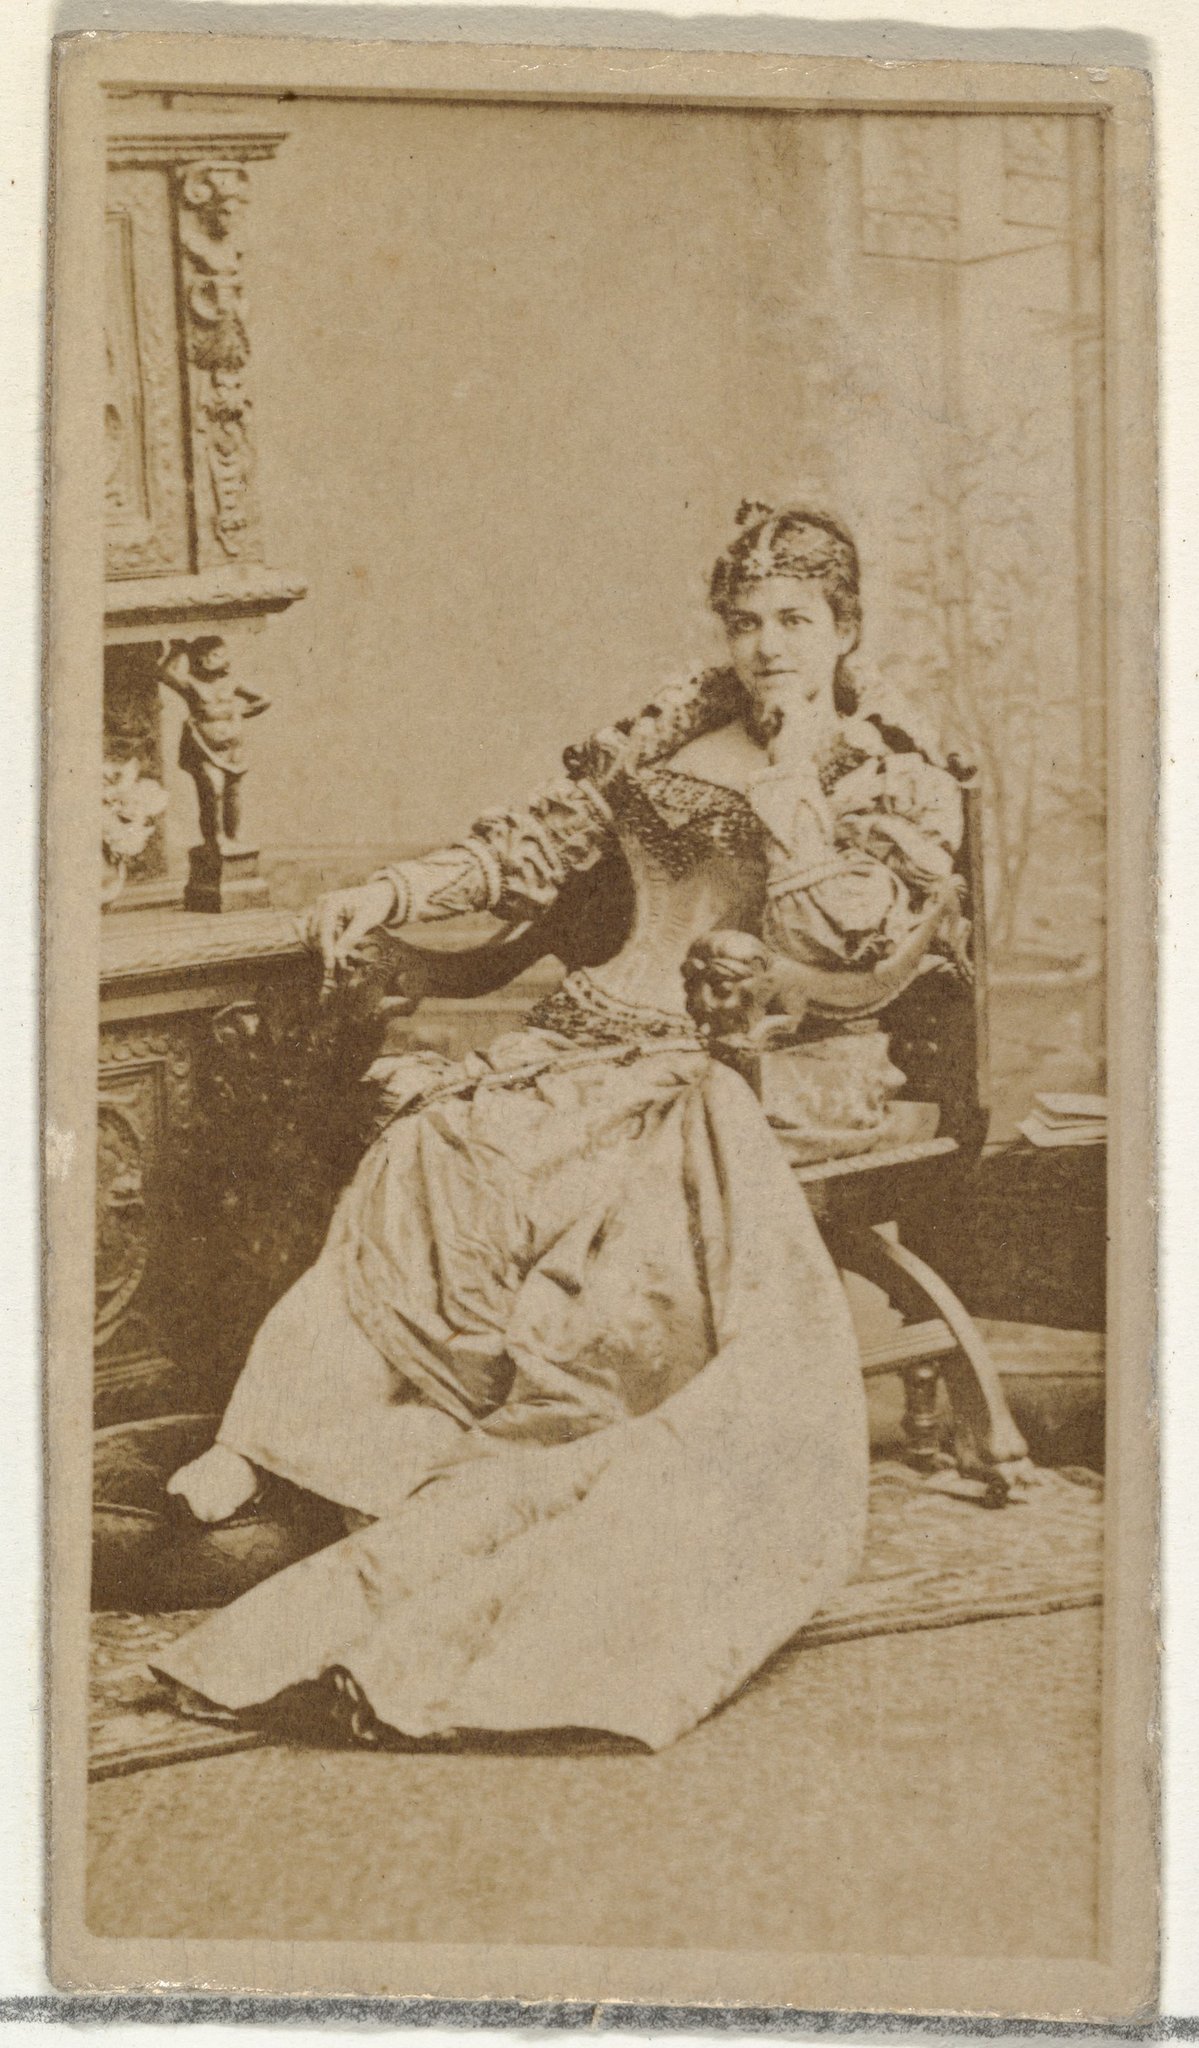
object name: photograph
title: [Actress in studio reclining in heavy wooden chair], from the Actors and Actresses series (N145-8) issued by Duke Sons & Co. to promote Duke Cigarettes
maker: w. duke, sons & co.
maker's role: publisher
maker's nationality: american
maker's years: 1870-1920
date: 1891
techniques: albumen silver print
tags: portraits,women,actresses